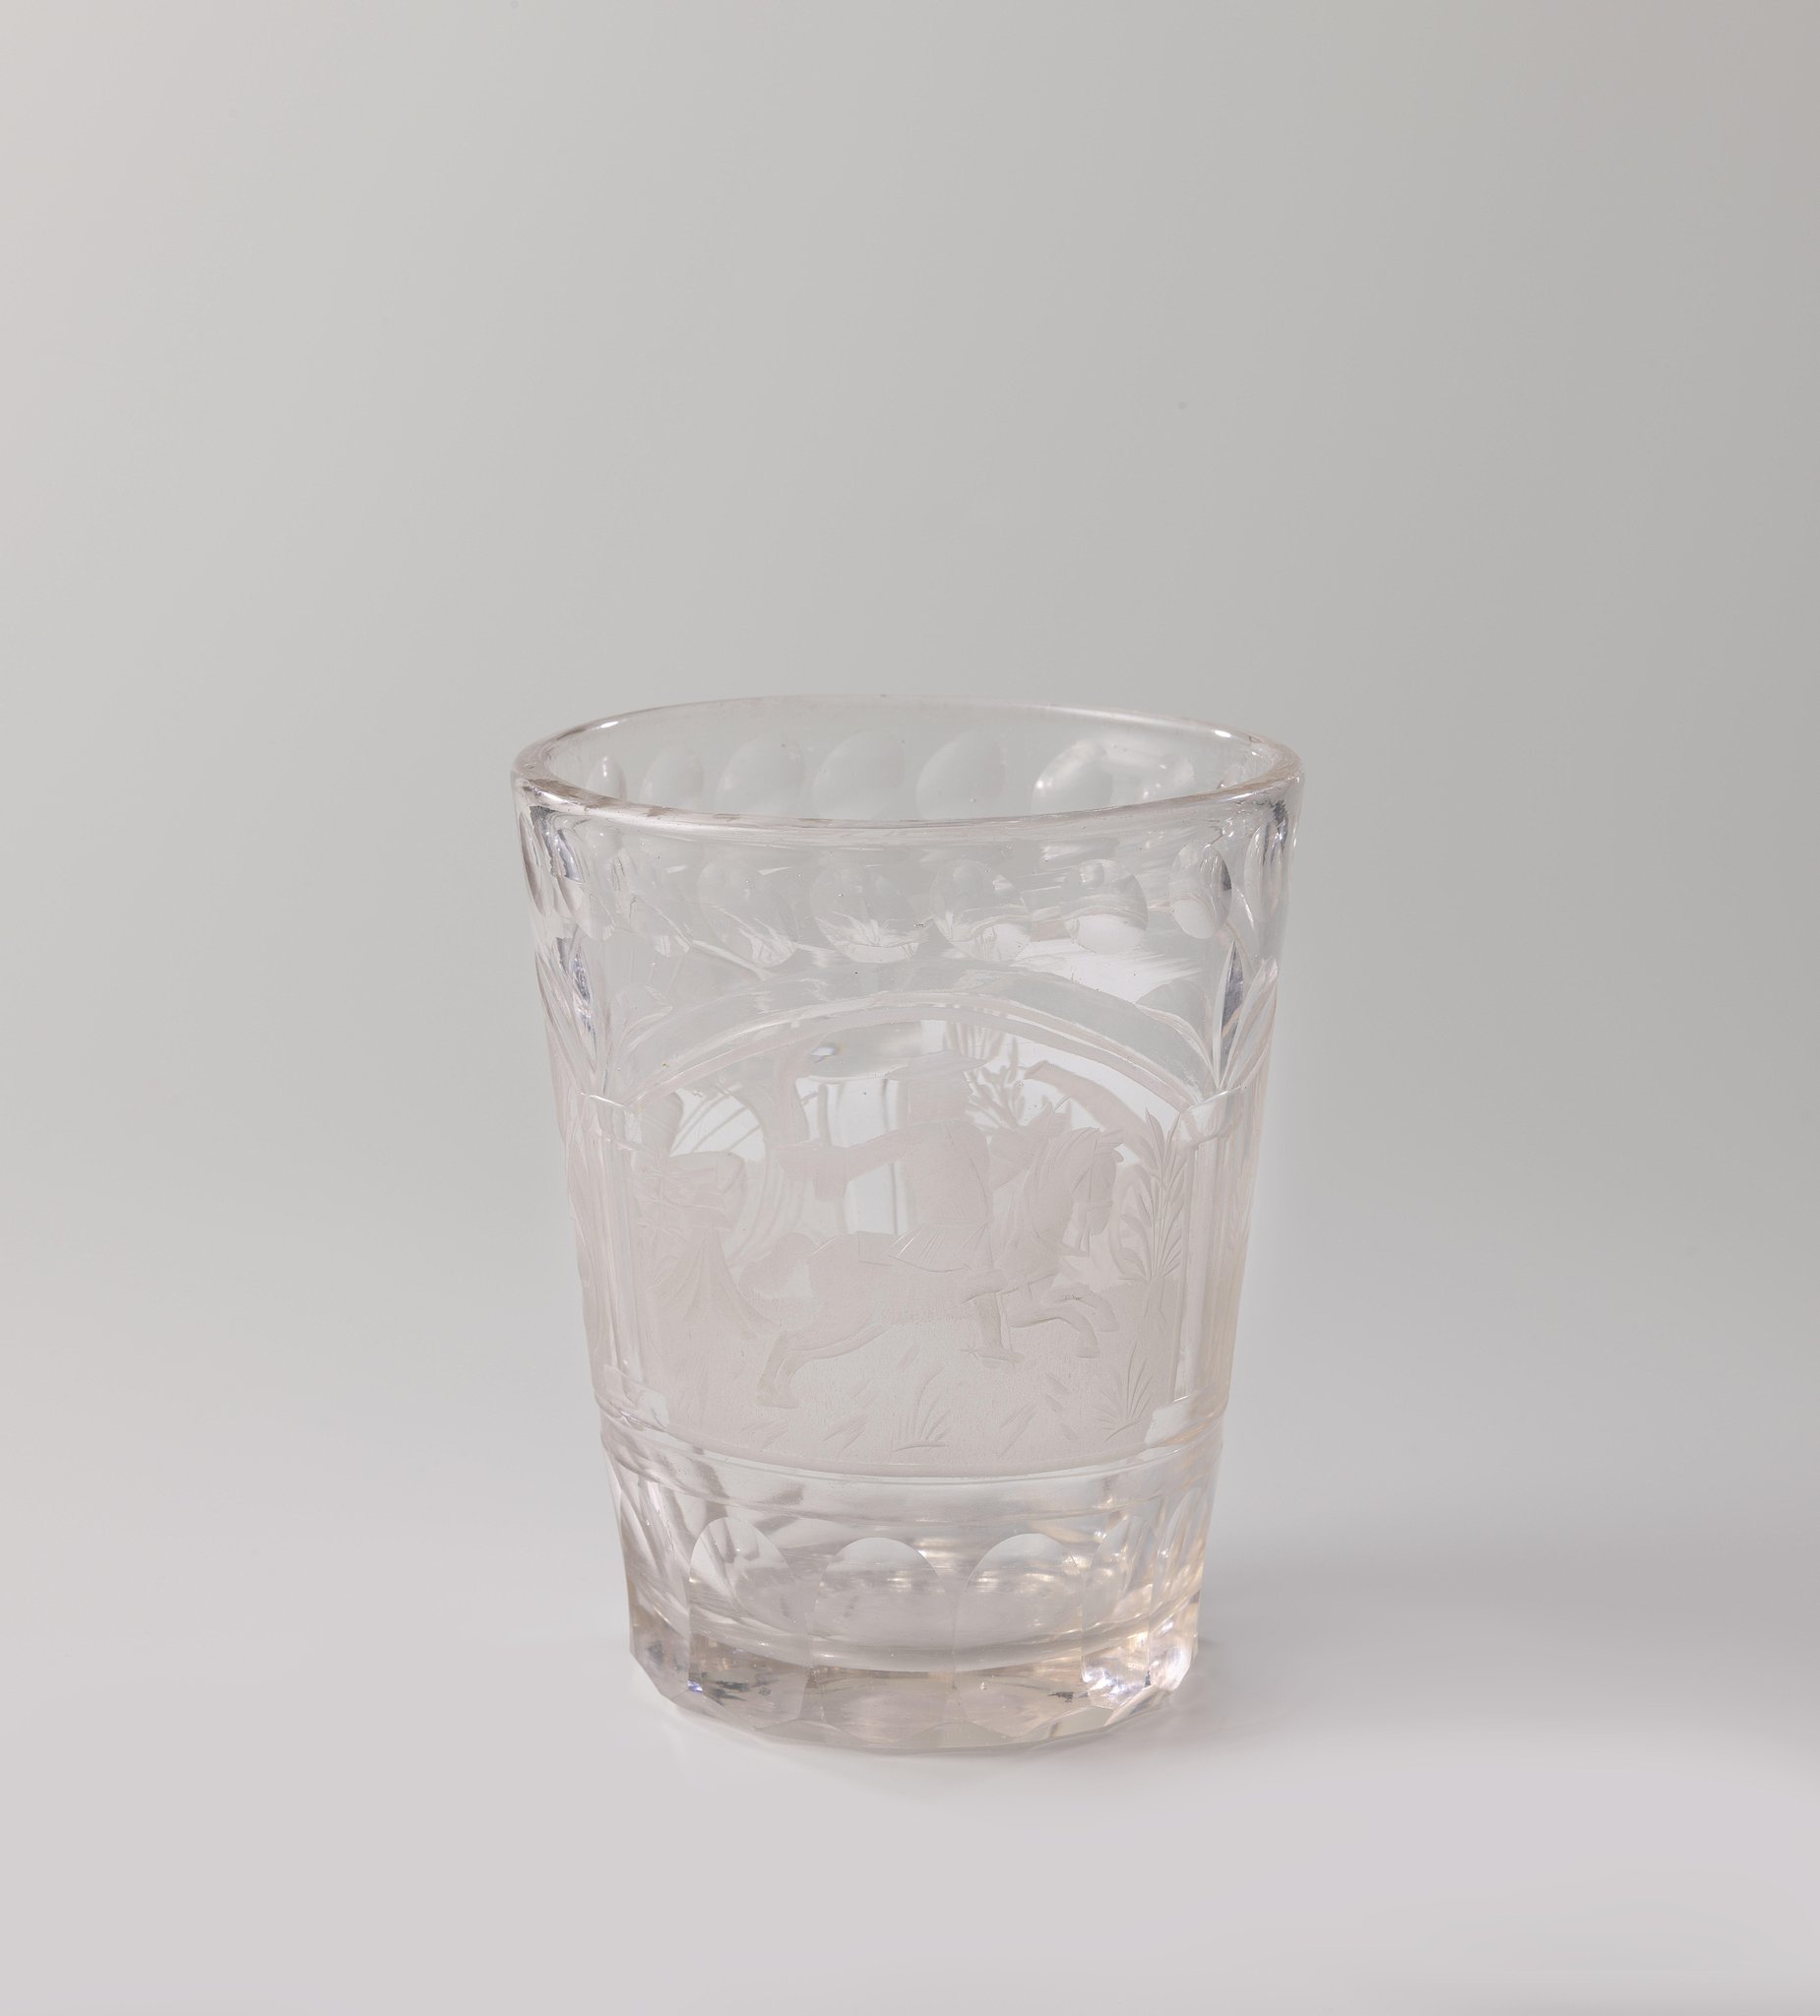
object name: cup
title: Beker met een kanonnier, een ruiter en een wapentrofee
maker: Anonymous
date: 1725-1775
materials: glass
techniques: glassblowing, grinding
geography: bohemia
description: Beker van helder, kleurloos glas, waarop een kanonnier, een ruiter en een wapentrofee.